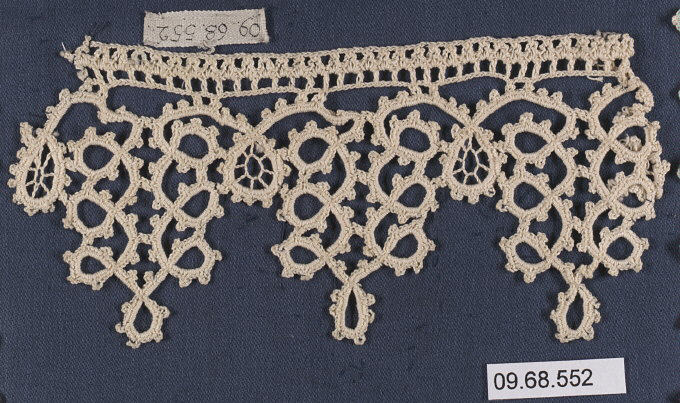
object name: specimen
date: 1801-1900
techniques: crochet